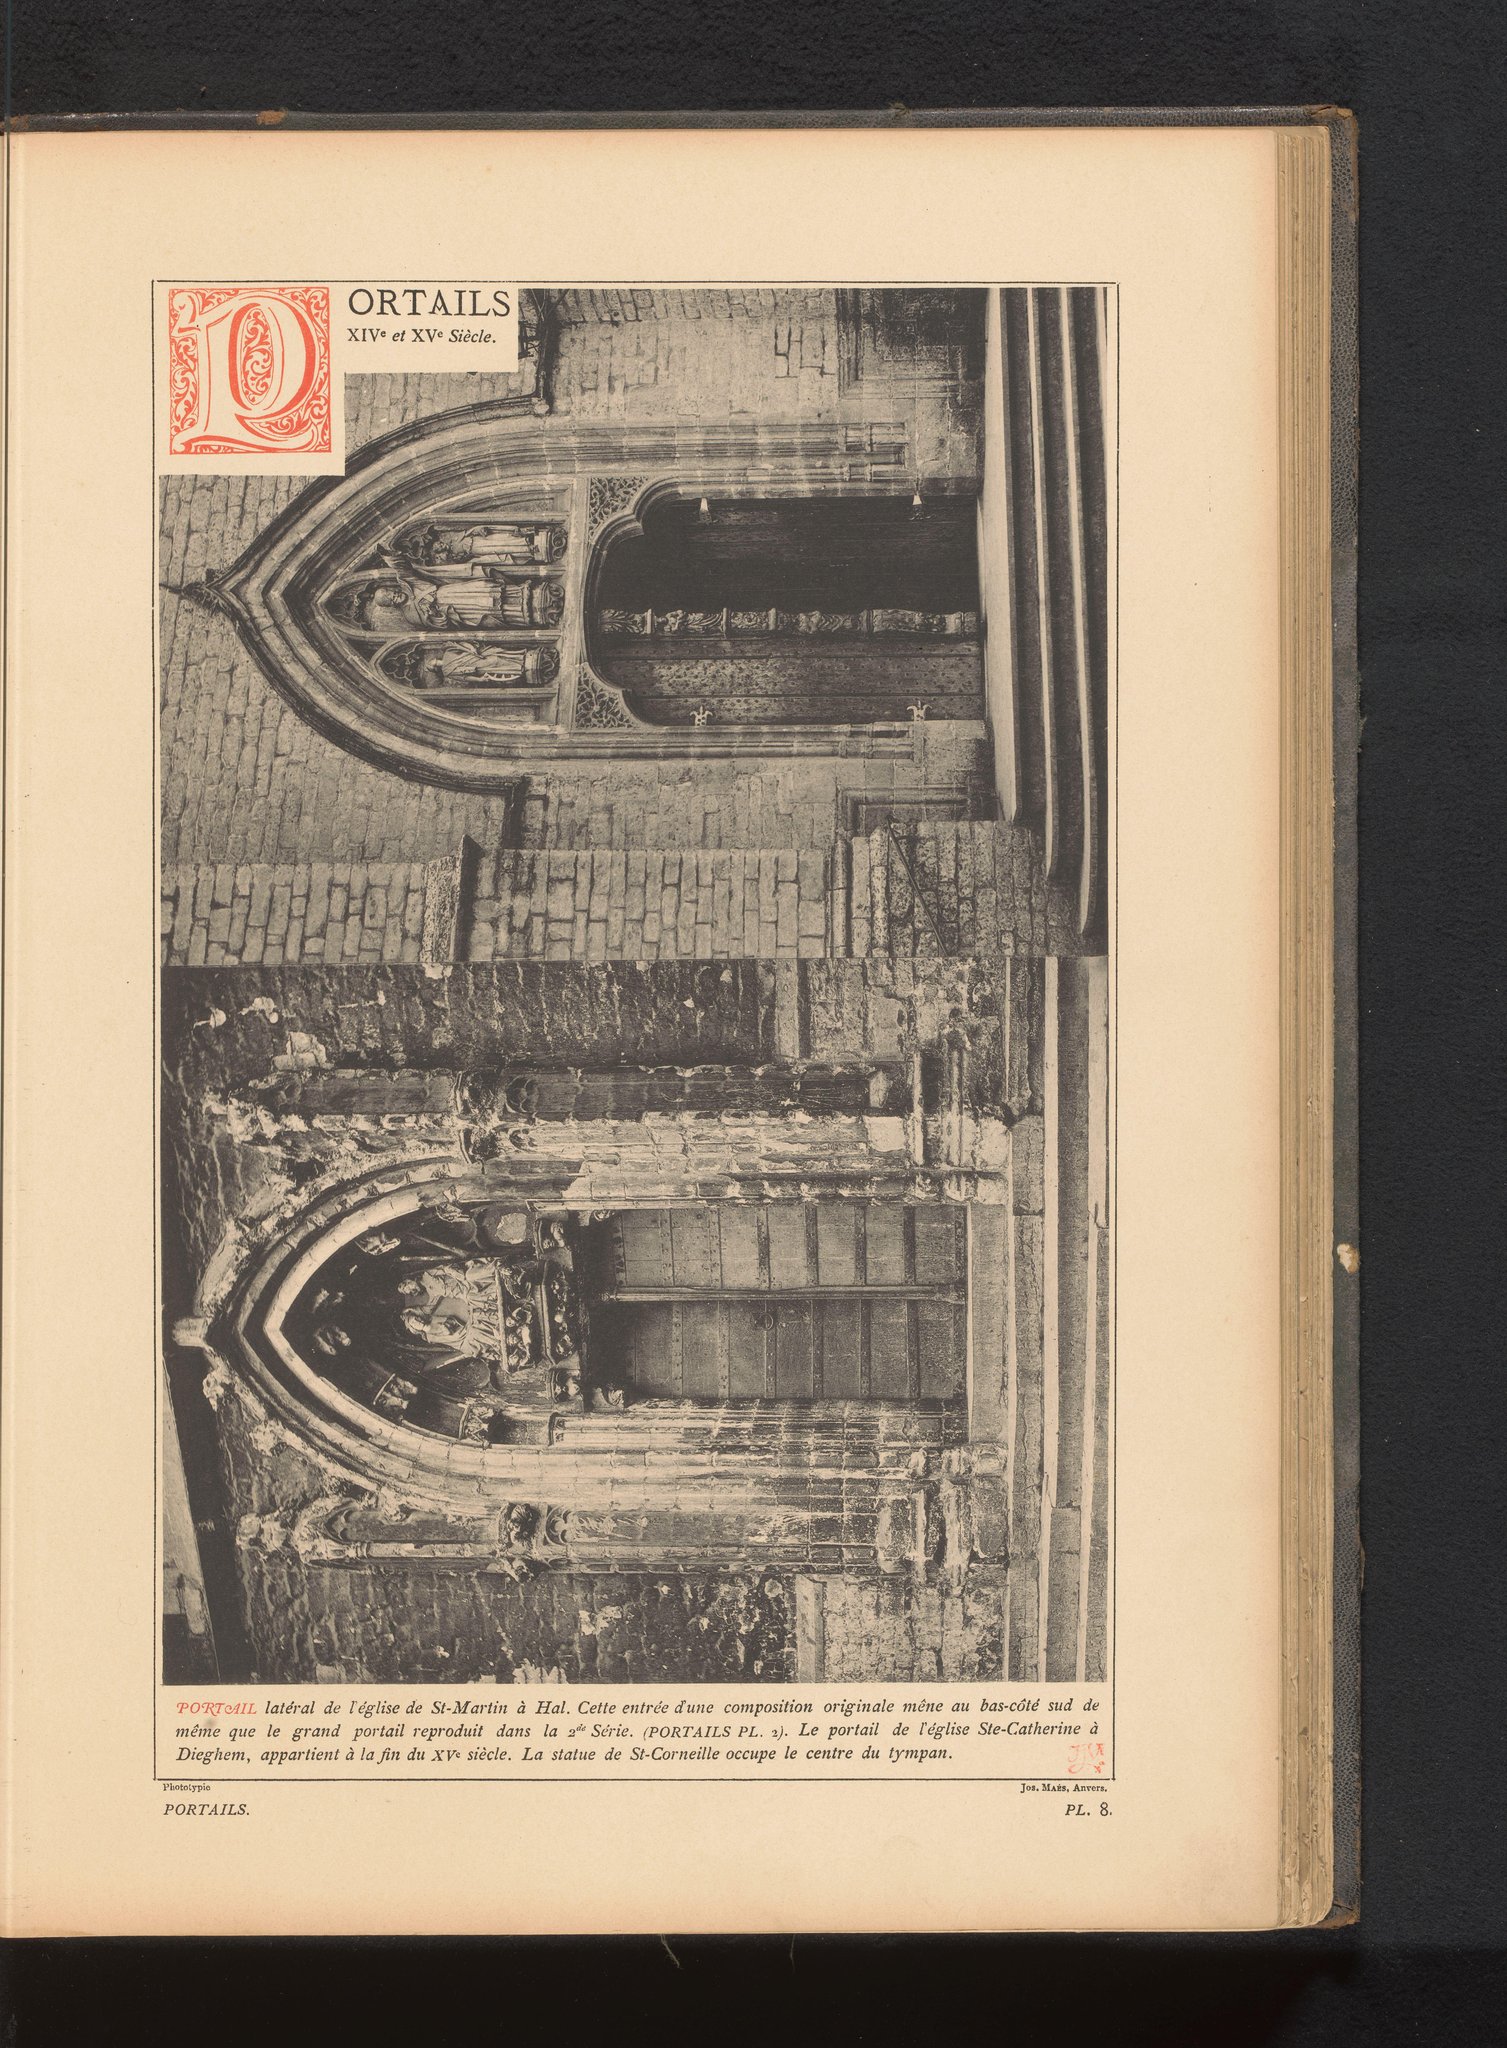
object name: photomechanical print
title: Zijportaal van de Sint-Martinusbasiliek te Halle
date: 1881-1889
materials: paper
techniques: photograph, photolithography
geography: antwerp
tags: parts of church exterior and annexes: portal, halle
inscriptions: inscription: ‘PORTAIL latéral de (...)’, inscription: ‘PORTAILS. PL. 8.’, monogram: ‘JJvY’